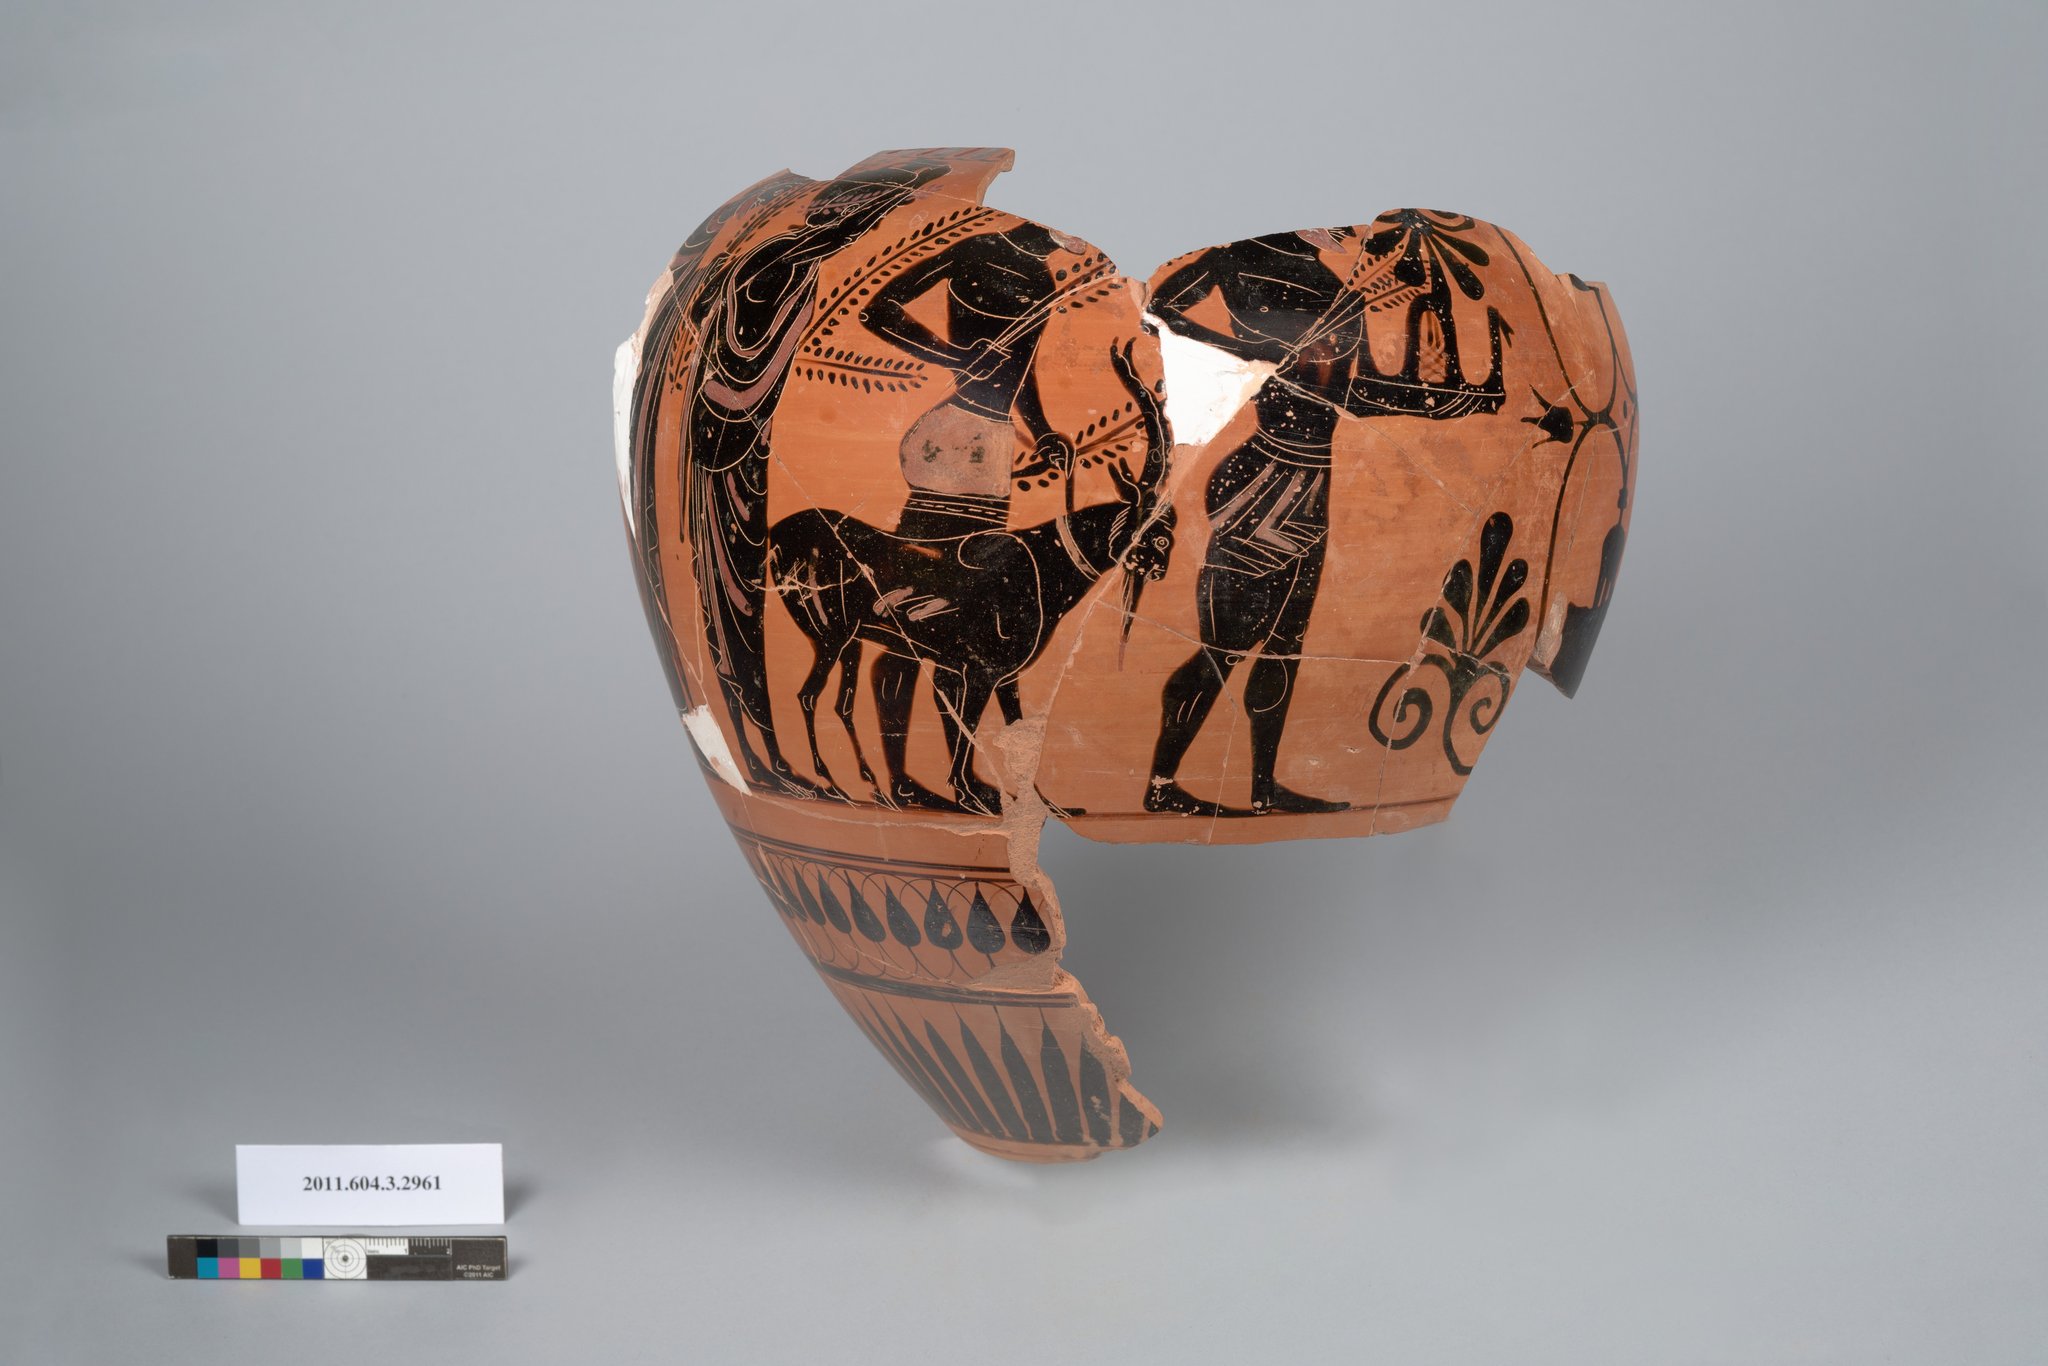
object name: neck amphora fragment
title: Terracotta fragment of a neck-amphora (jar)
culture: greek, attic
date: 550-526 BCE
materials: terracotta